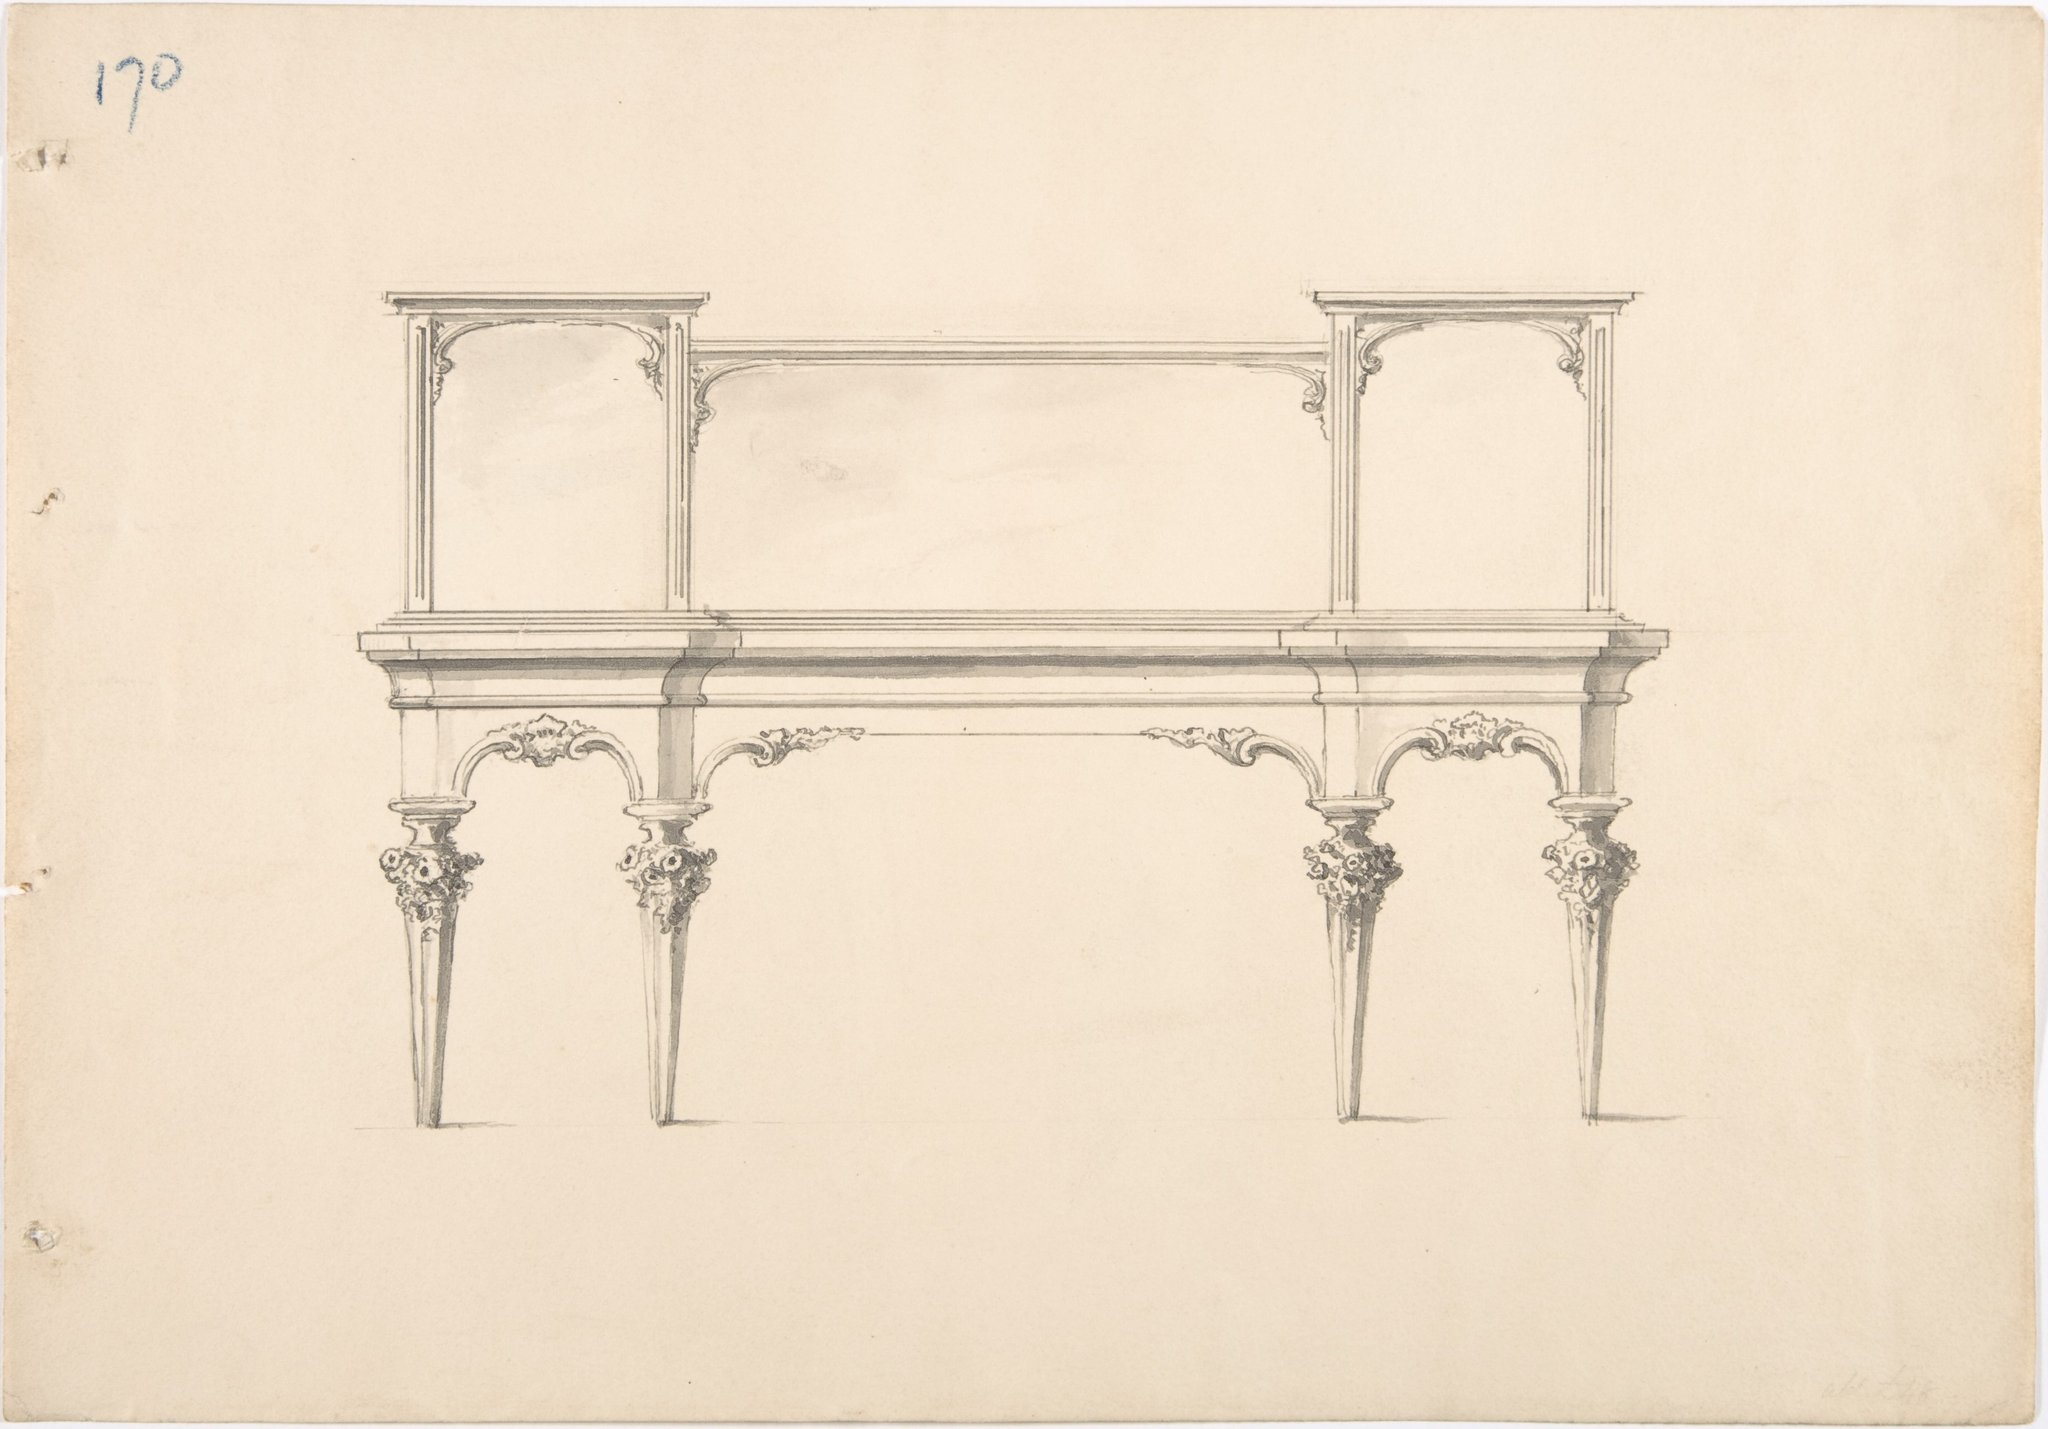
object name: drawing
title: Design for a Mirrored Sideboard with Pointed Legs and Floral Ornament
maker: anonymous, british, 19th century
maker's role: artist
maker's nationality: british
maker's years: 1800-1900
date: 1801-1833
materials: ink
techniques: brush, pen, wash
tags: flowers,mirrors